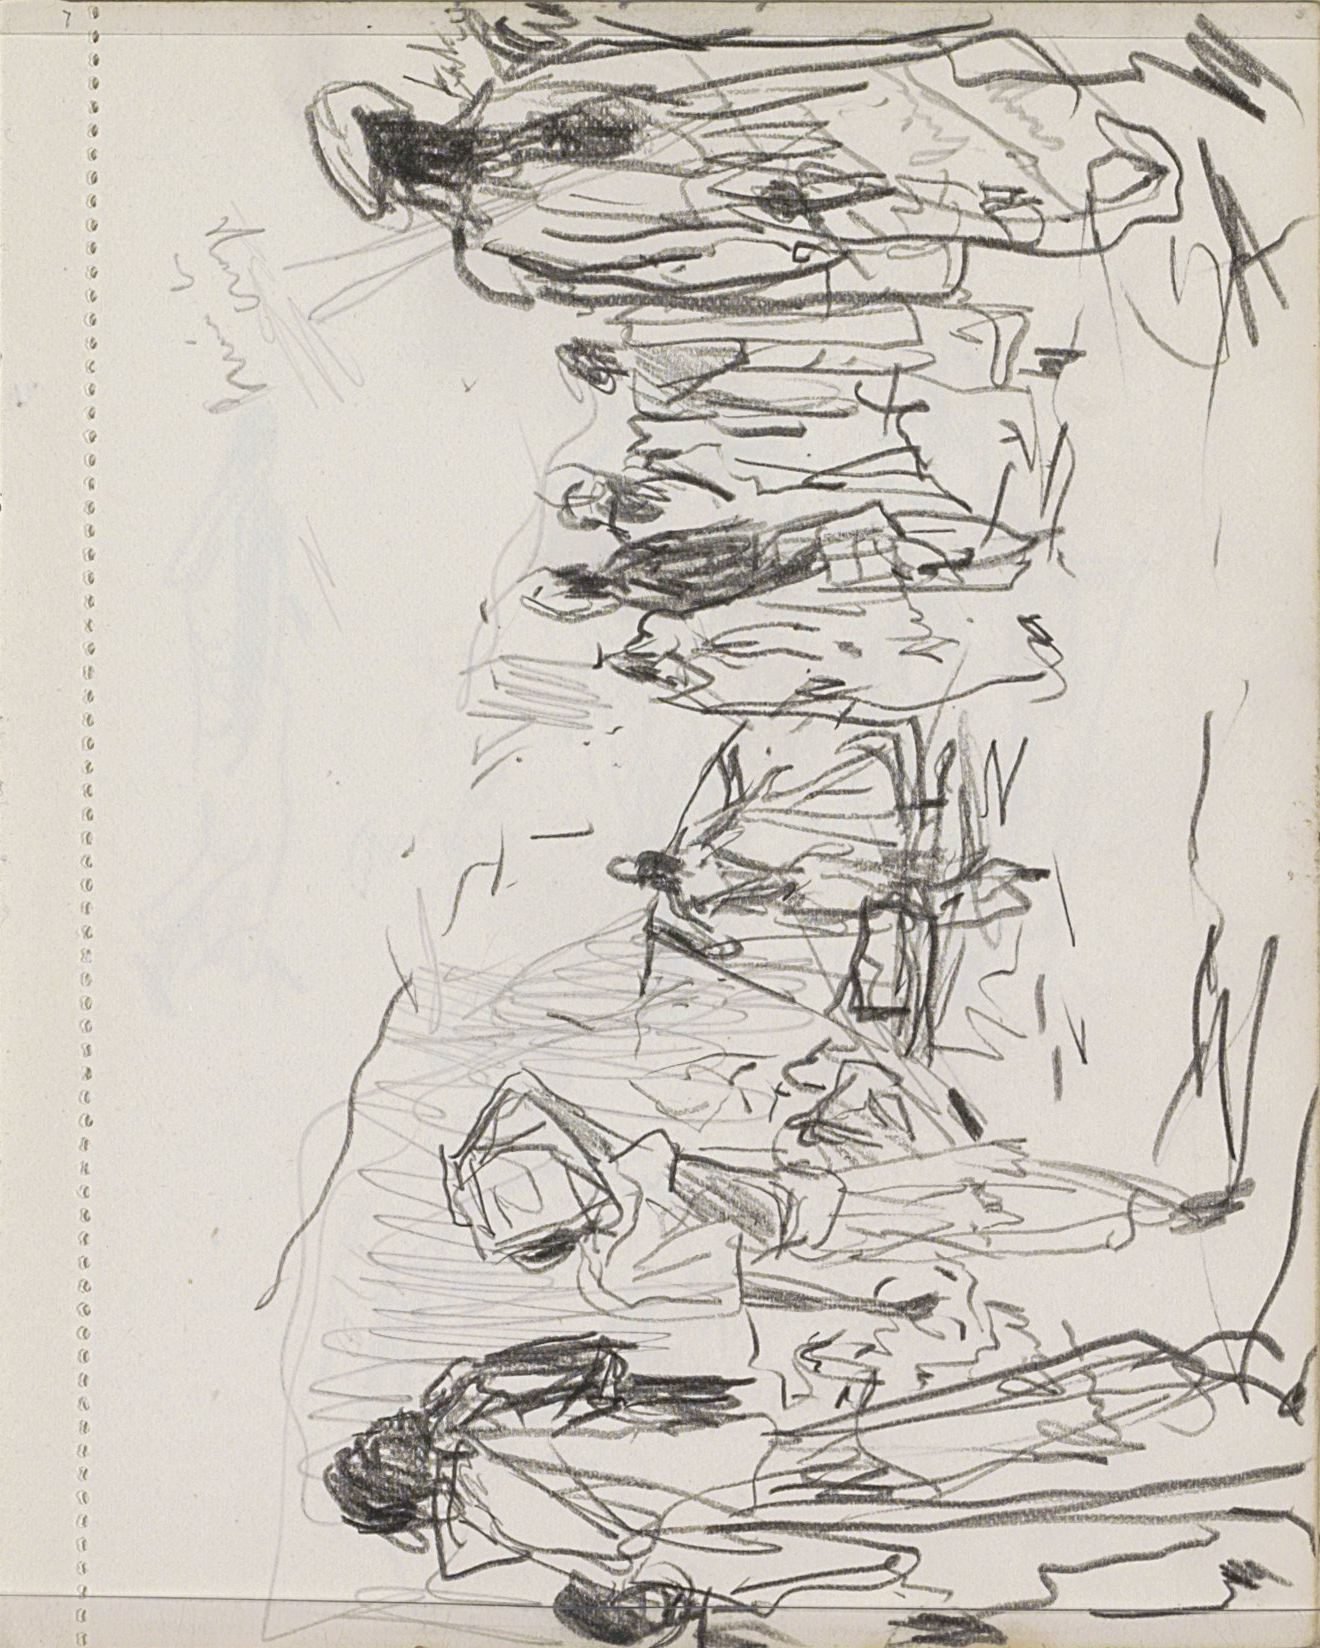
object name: sketchbook leaf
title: Indiërs, vermoedelijk op een markt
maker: marius bauer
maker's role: draughtsman, print maker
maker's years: 1867-1932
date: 1924-1925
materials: chalk, paper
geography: india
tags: carrying something, locations for trading, persons engaged in trade and commerce, asiatic races and peoples: indians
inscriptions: kleurnotitie, handgeschreven in potlood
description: De figuren dragen water en pakken op de schouders. Pagina 7 uit een schetsboek met 75 bladen.